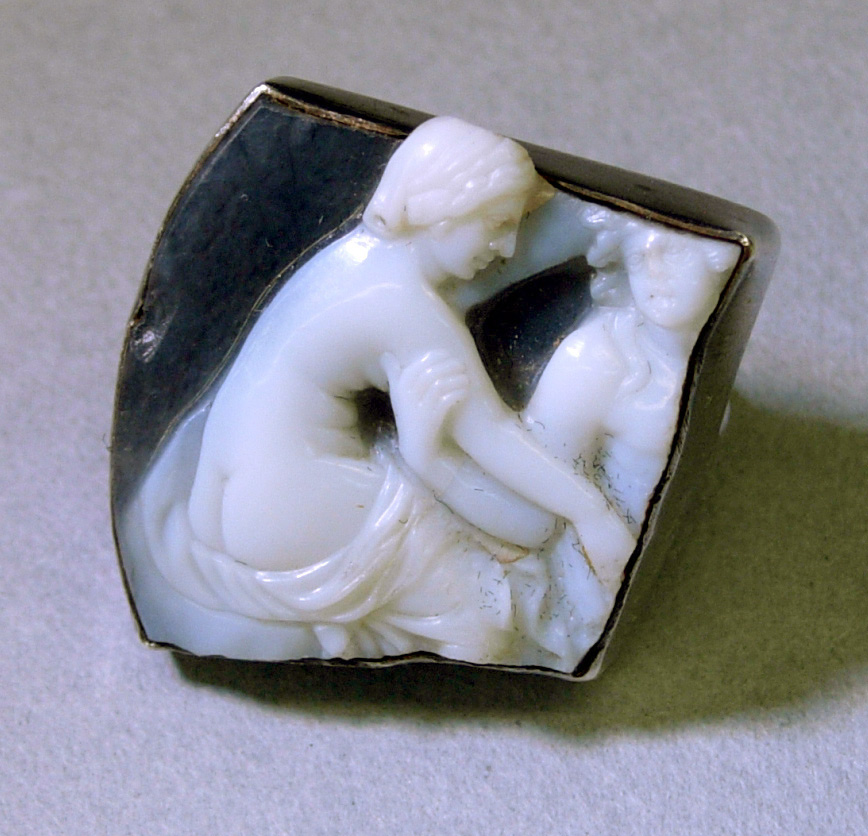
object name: cameo, fragment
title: Sardonyx cameo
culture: roman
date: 1-100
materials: gemstone